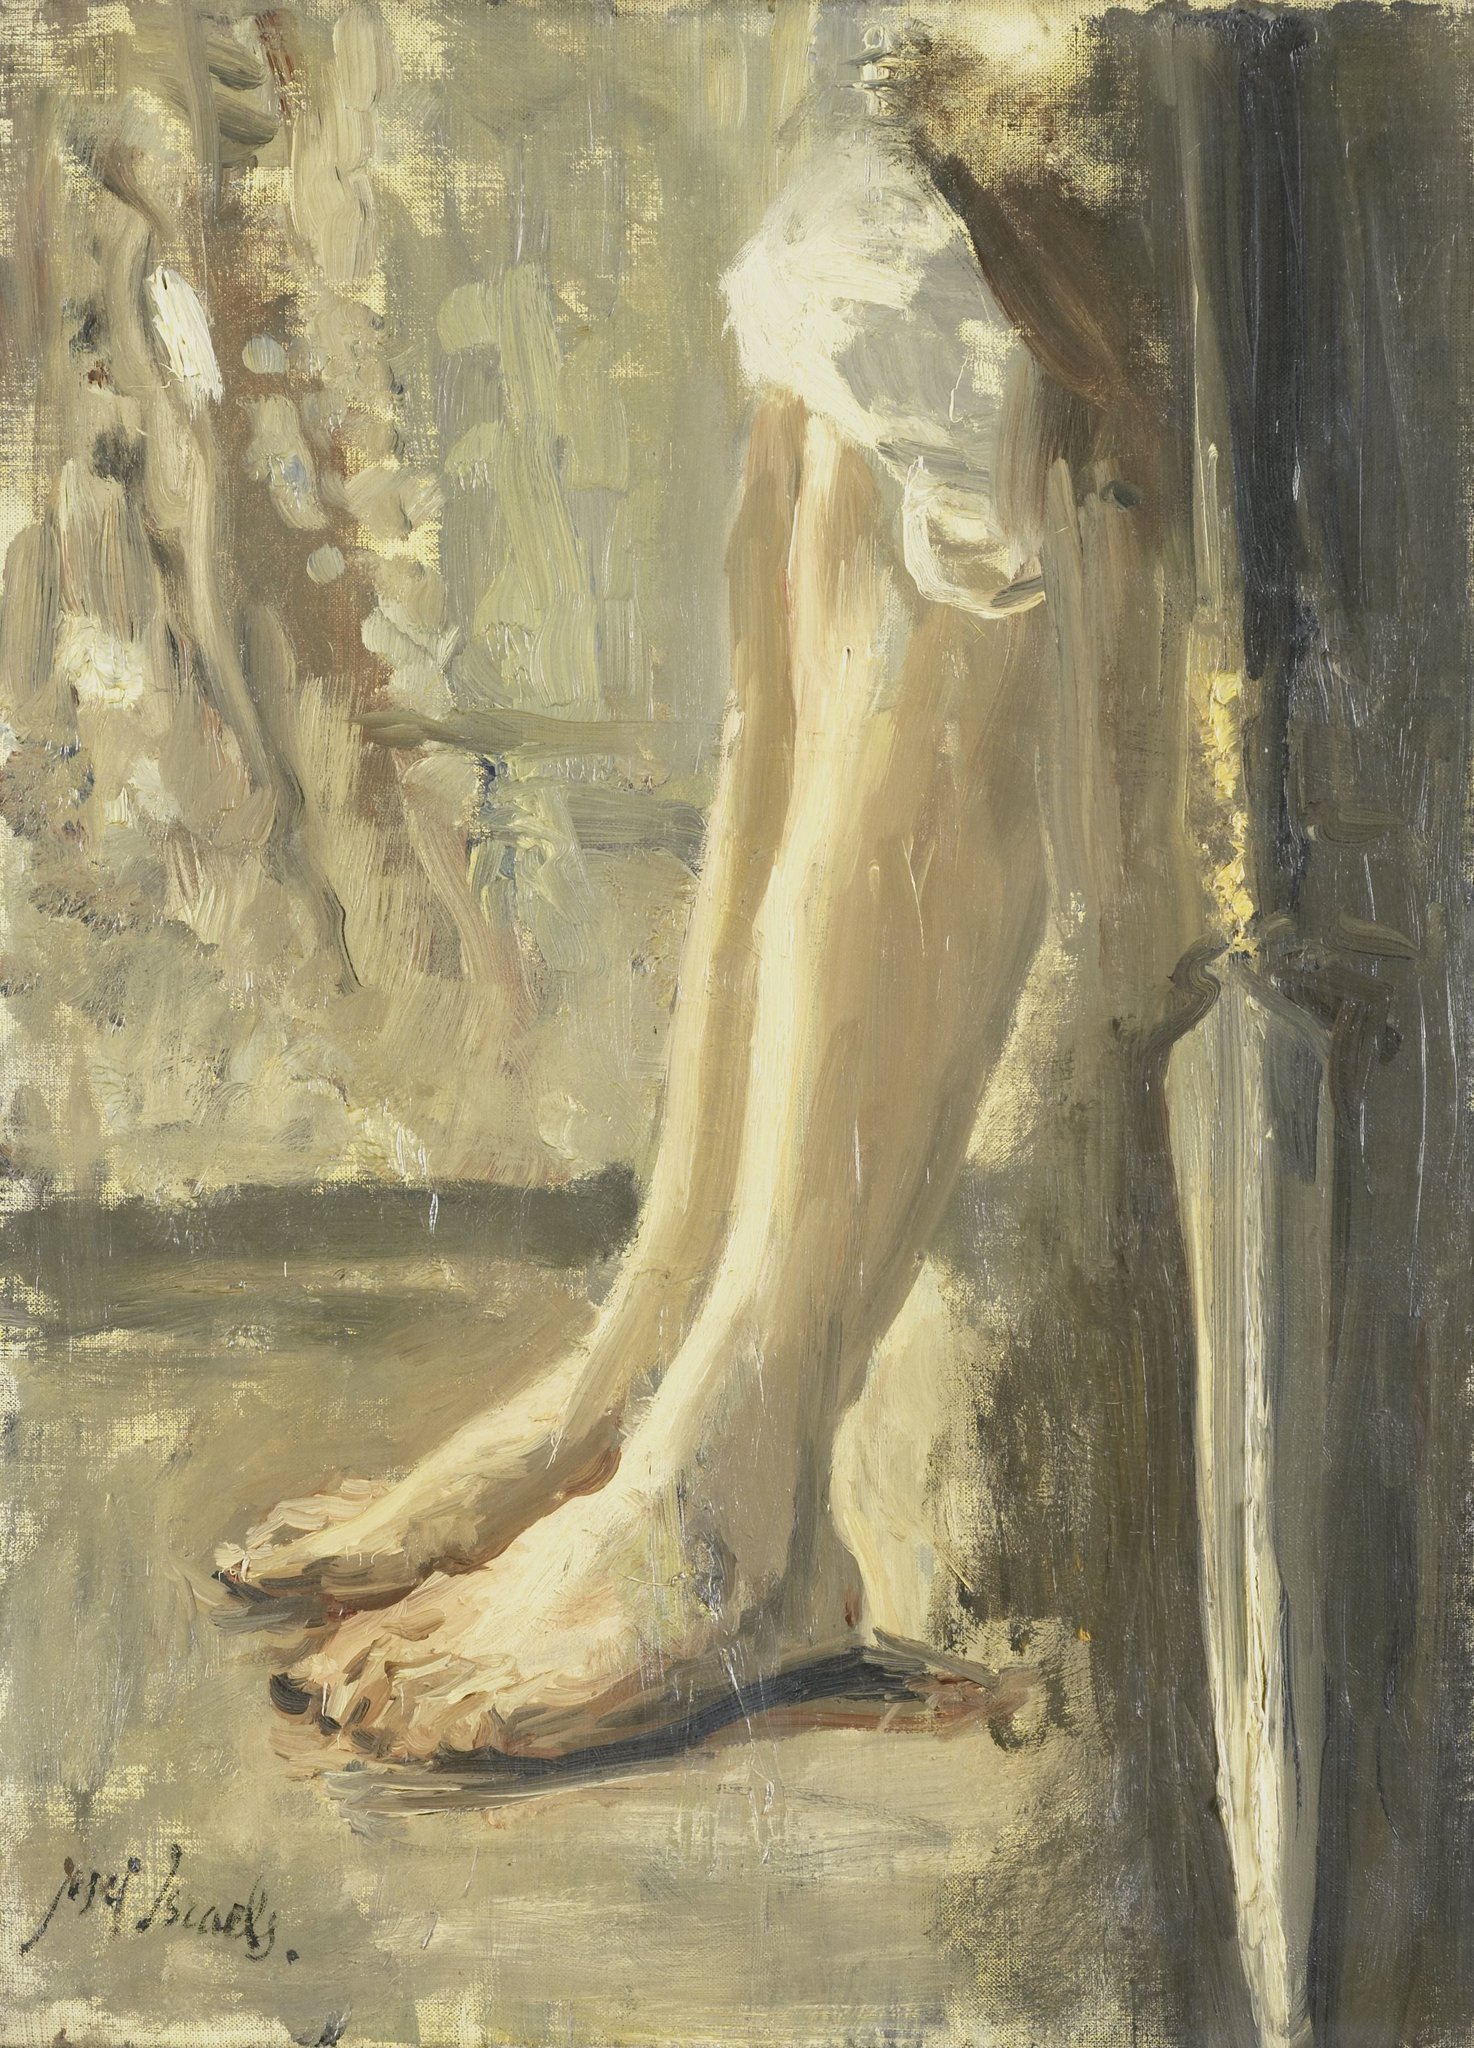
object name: painting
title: David's Legs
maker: jozef israëls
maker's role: draughtsman, painter, print maker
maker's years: 1824-1911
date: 1899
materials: canvas, oil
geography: netherlands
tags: lower leg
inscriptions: signature: ‘Jozef Israels’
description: Studie voor de benen van David. Uit een reeks van vijf studies voor een schilderij van Saul en David uit 1899 (zie ook SK-A-3731, SK-A-3730, SK- A-4198 en SK-A-3732).